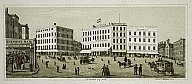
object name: print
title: Chatham Square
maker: charles magnus & company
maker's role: publisher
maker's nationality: american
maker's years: 1854-1880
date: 1850-1900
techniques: hand coloring, engraving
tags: buildings,cities,carriages,new york city